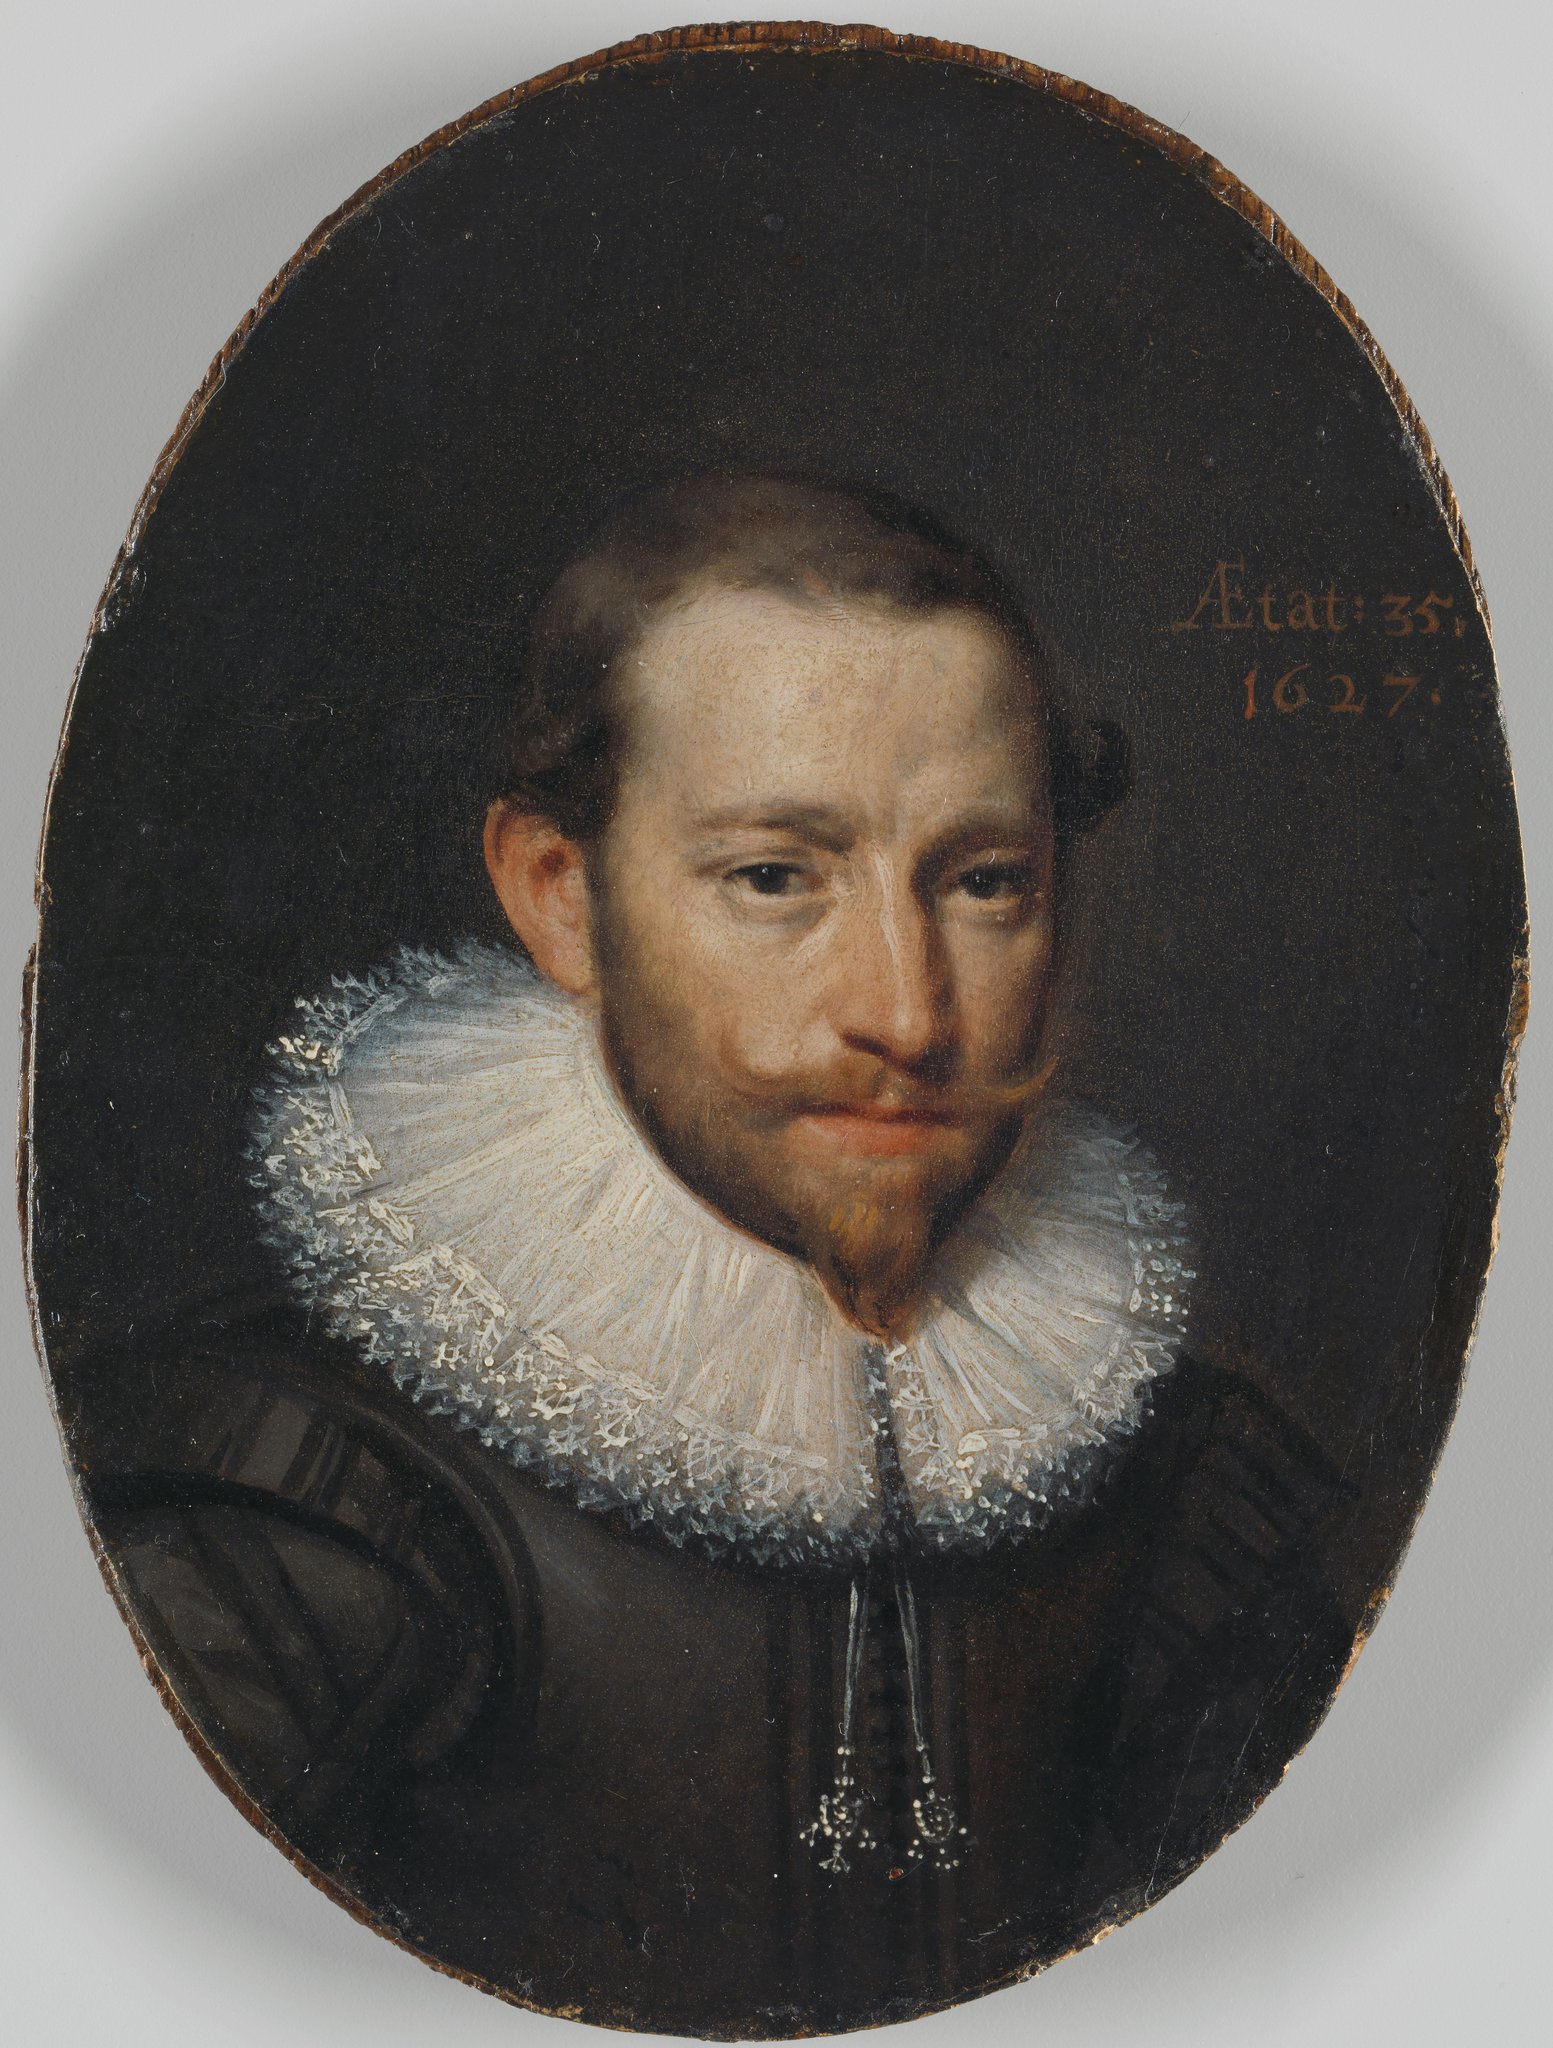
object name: painting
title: Portrait of a man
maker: Anonymous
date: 1627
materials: oil, panel, paper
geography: northern netherlands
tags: anonymous historical person portrayed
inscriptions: inscription and date: ‘AEtat: 35. 1627.’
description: Portret van een man, buste naar rechts. Behoort bij SK-A-2080.